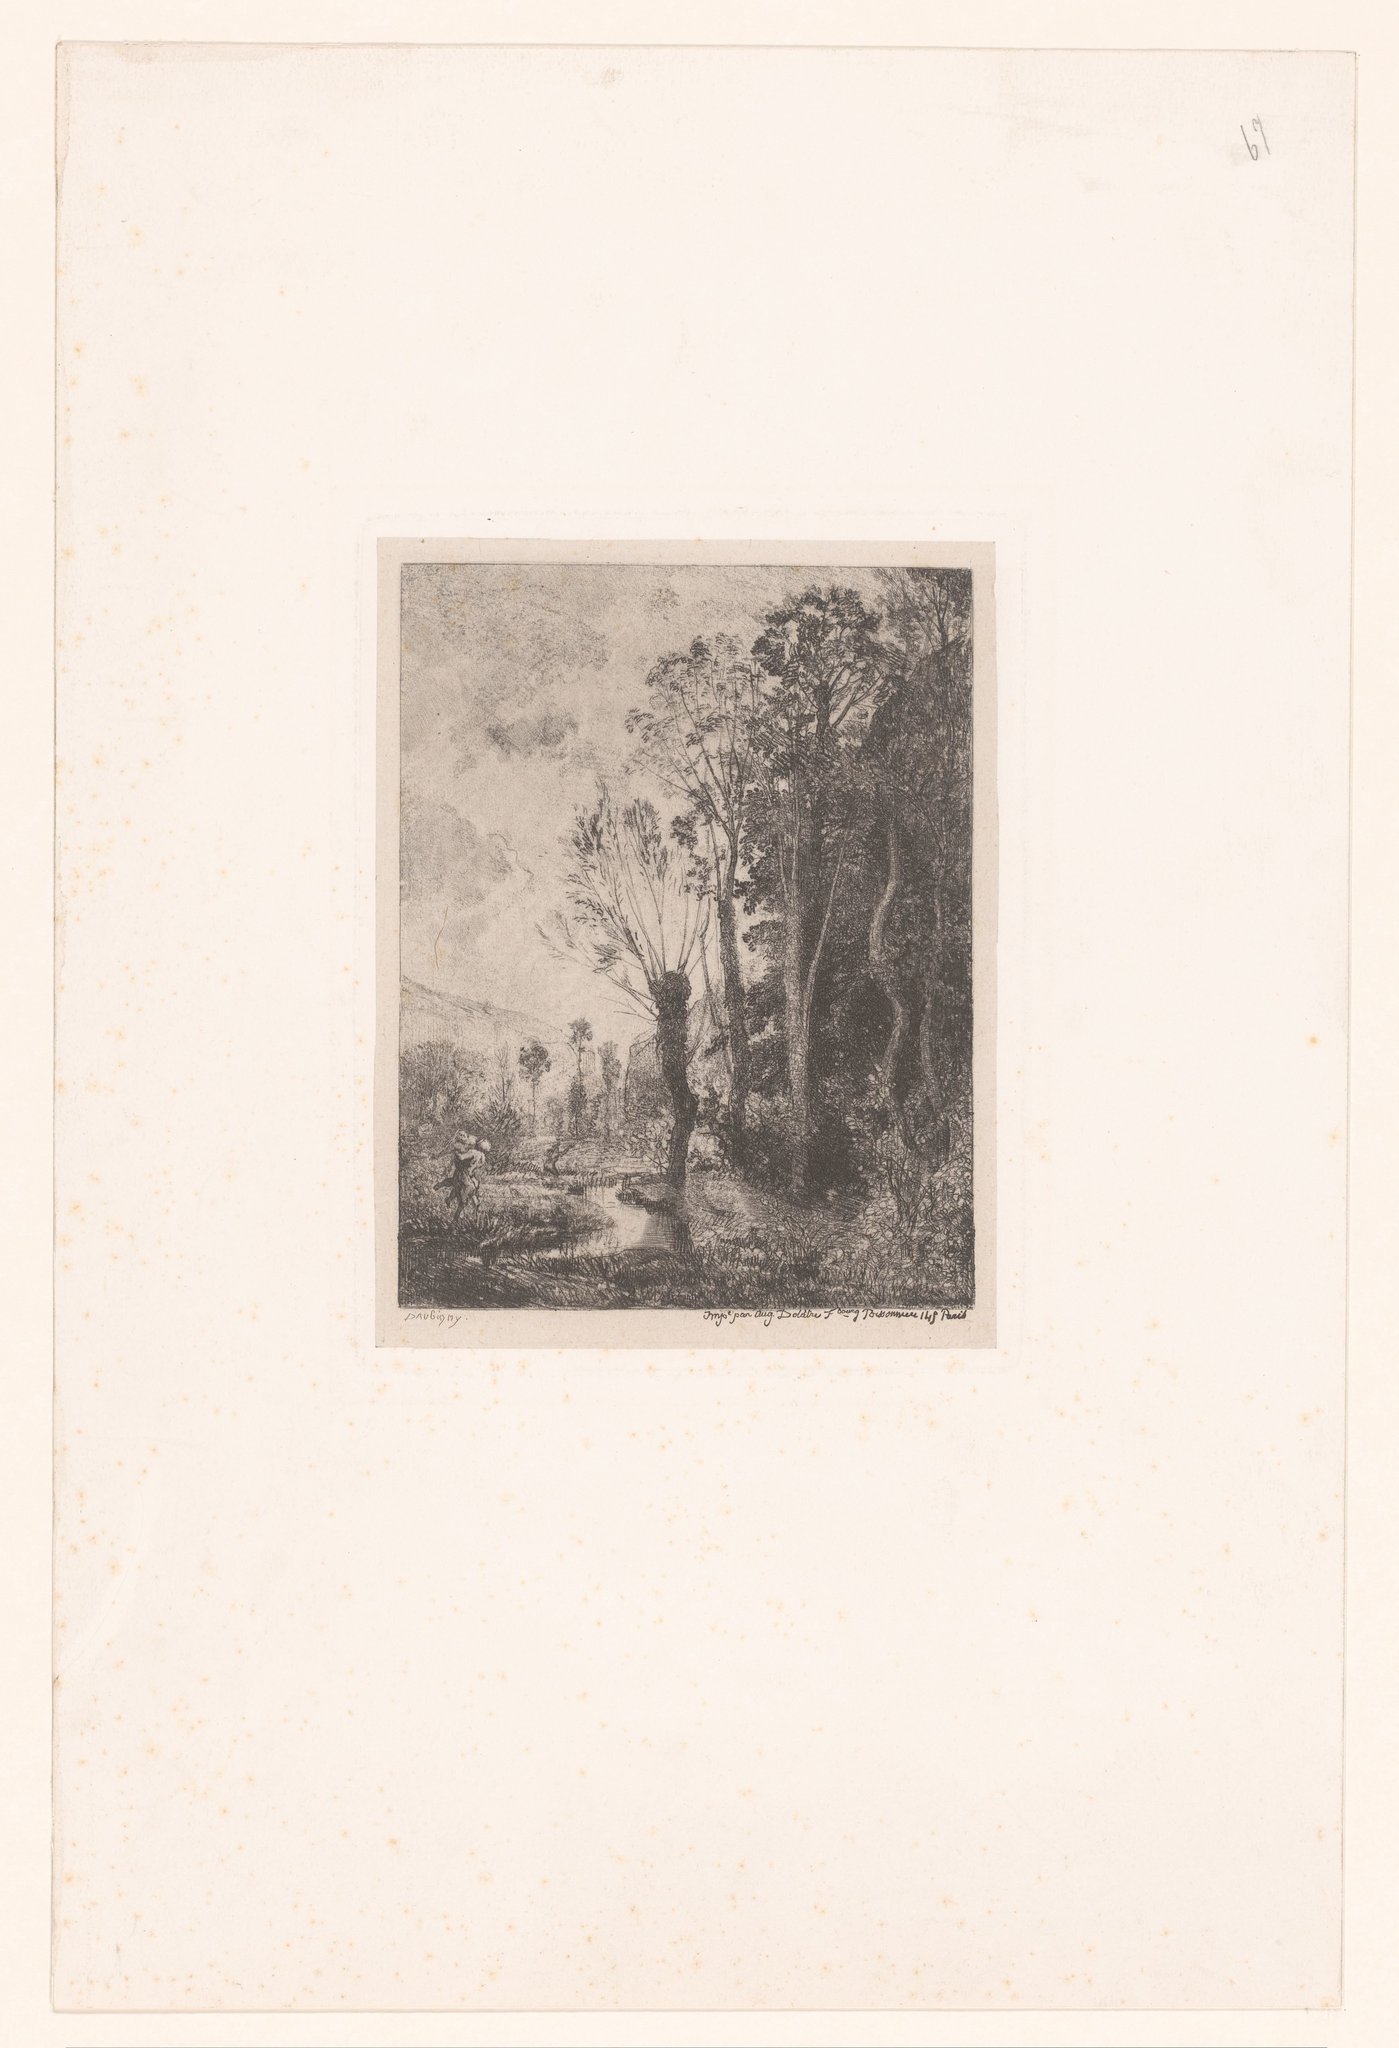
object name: print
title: Le Satyre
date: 1850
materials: paper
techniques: etching, roulette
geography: paris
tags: landscapes, water course, satyr(s) (in general)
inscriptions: collector's mark: Lugt 2228